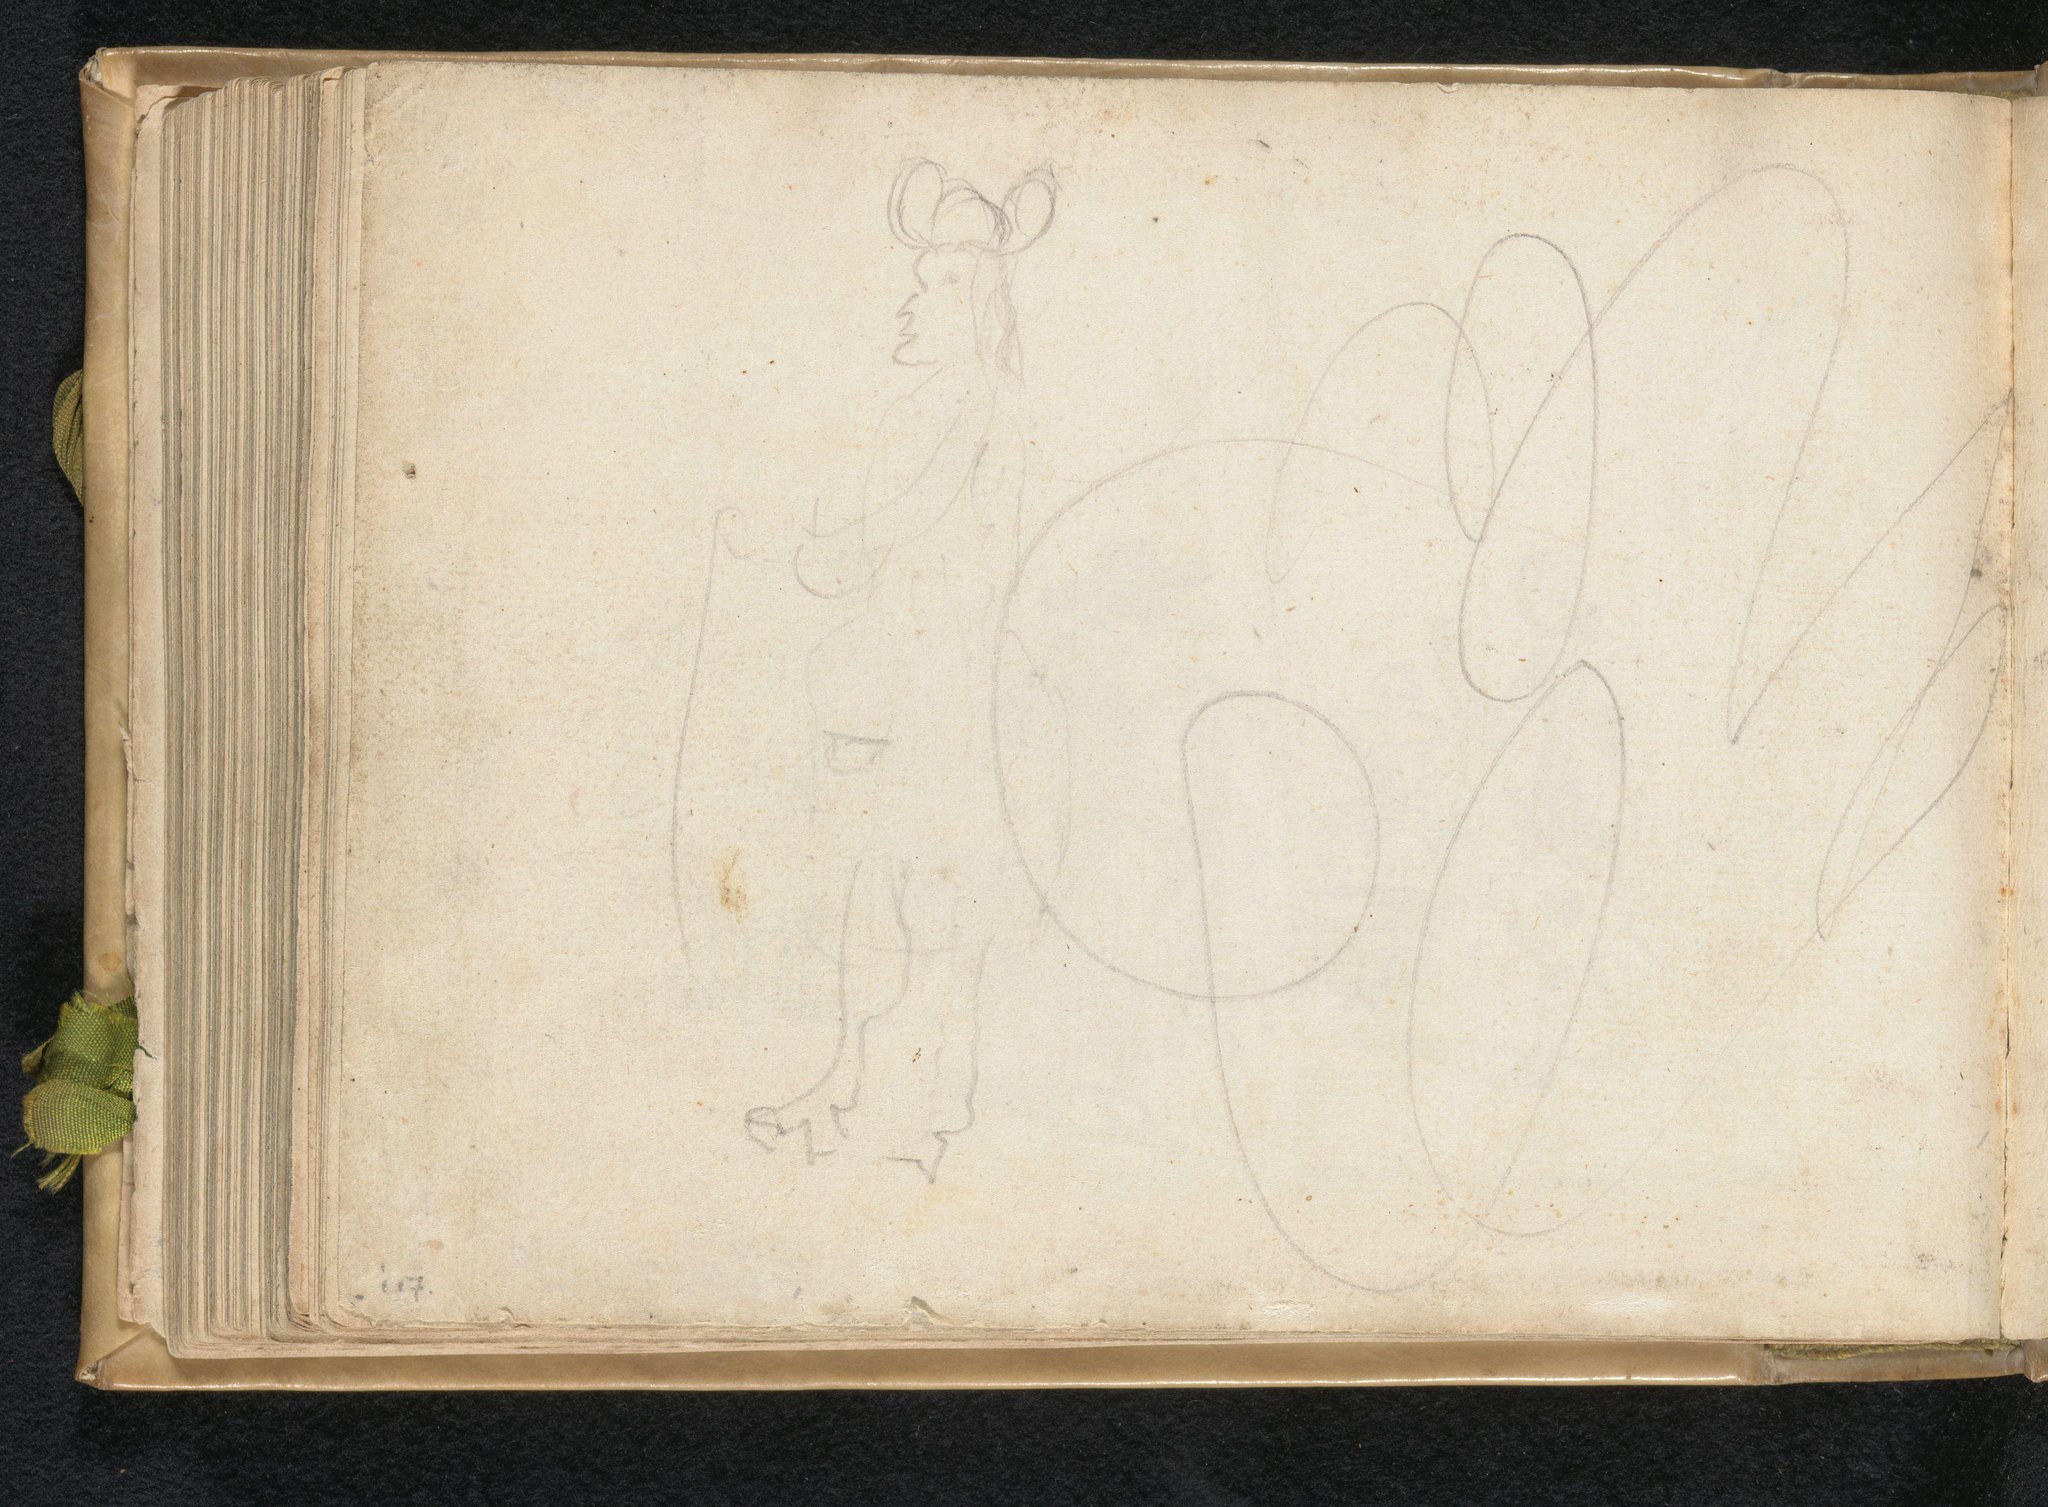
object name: sketchbook leaf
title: Scratches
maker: Anonymous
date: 1671-1699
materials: paper, pencil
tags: sri lanka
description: Potloodkrabbels rechts op het papier. Links een onduidelijke en onbeholpen potloodschets van een man met helm. Deze krabbels staan op de verso-zijde van blad 116. Ze zijn zeker niet van Boursse zelf, maar ze zijn later (ná 1671) door een onbekend persoon gemaakt. Blad 117 uit een schetsboek met 117 bladen.